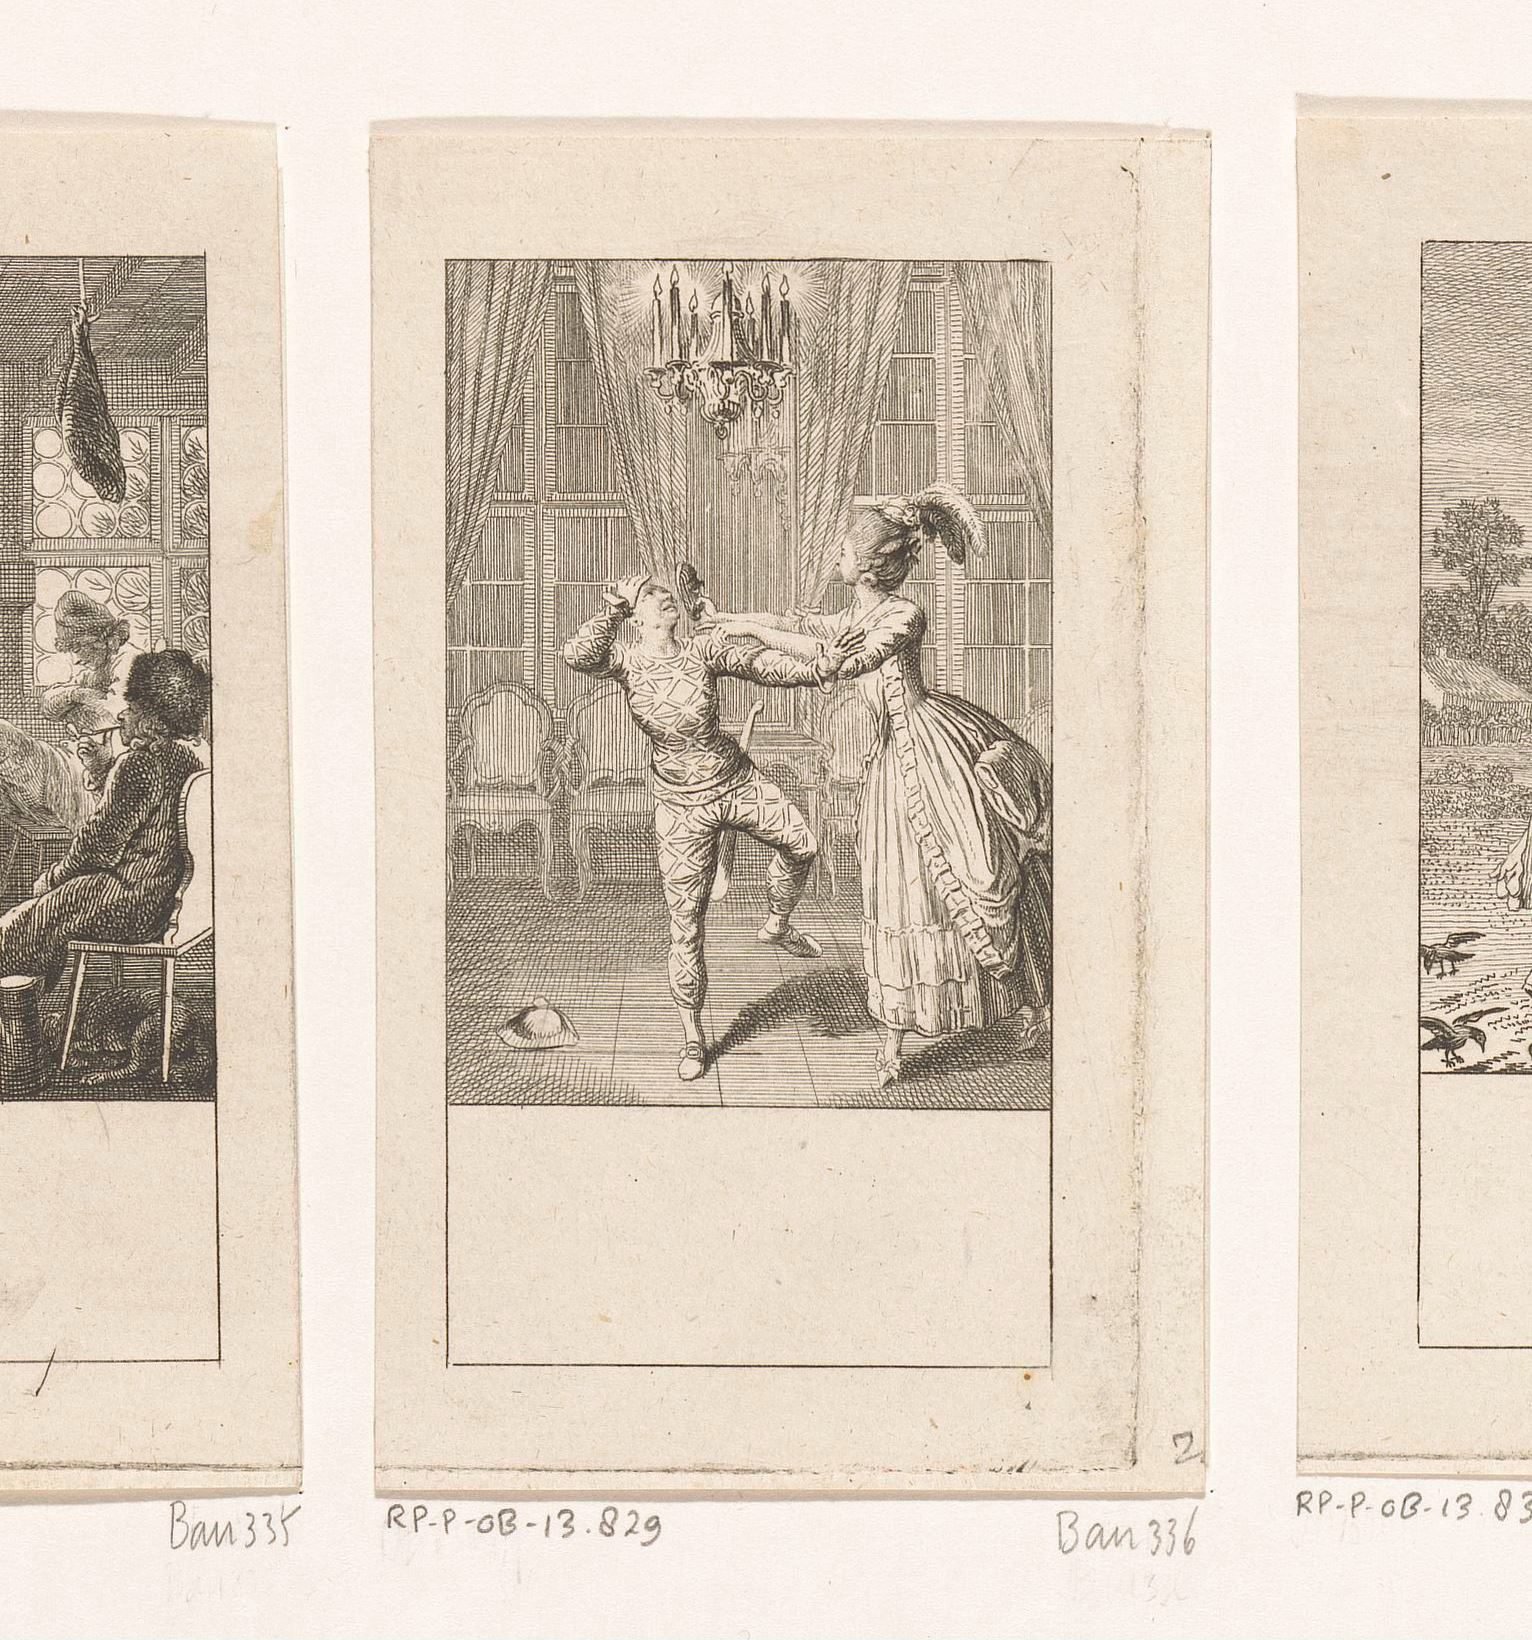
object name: print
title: Februari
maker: daniel nikolaus chodowiecki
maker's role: draughtsman, print maker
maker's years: 1726-1801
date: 1777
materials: paper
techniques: etching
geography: berlin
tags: mask, february and its 'labours', types in 'commedia dell'arte': harlequin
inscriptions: collector's mark: Lugt 2228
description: Afkomstig uit een serie met de twaalf maanden. Deze serie werd op een plaat geëtst. Een latere staat van deze serie werd gebruikt in: Königl. Großbrit. Churf. Braunschw. Lüneb. Genealogischen Kalender, auf das Jahr 1778. Lauenburg: Johann Georg Berenberg.